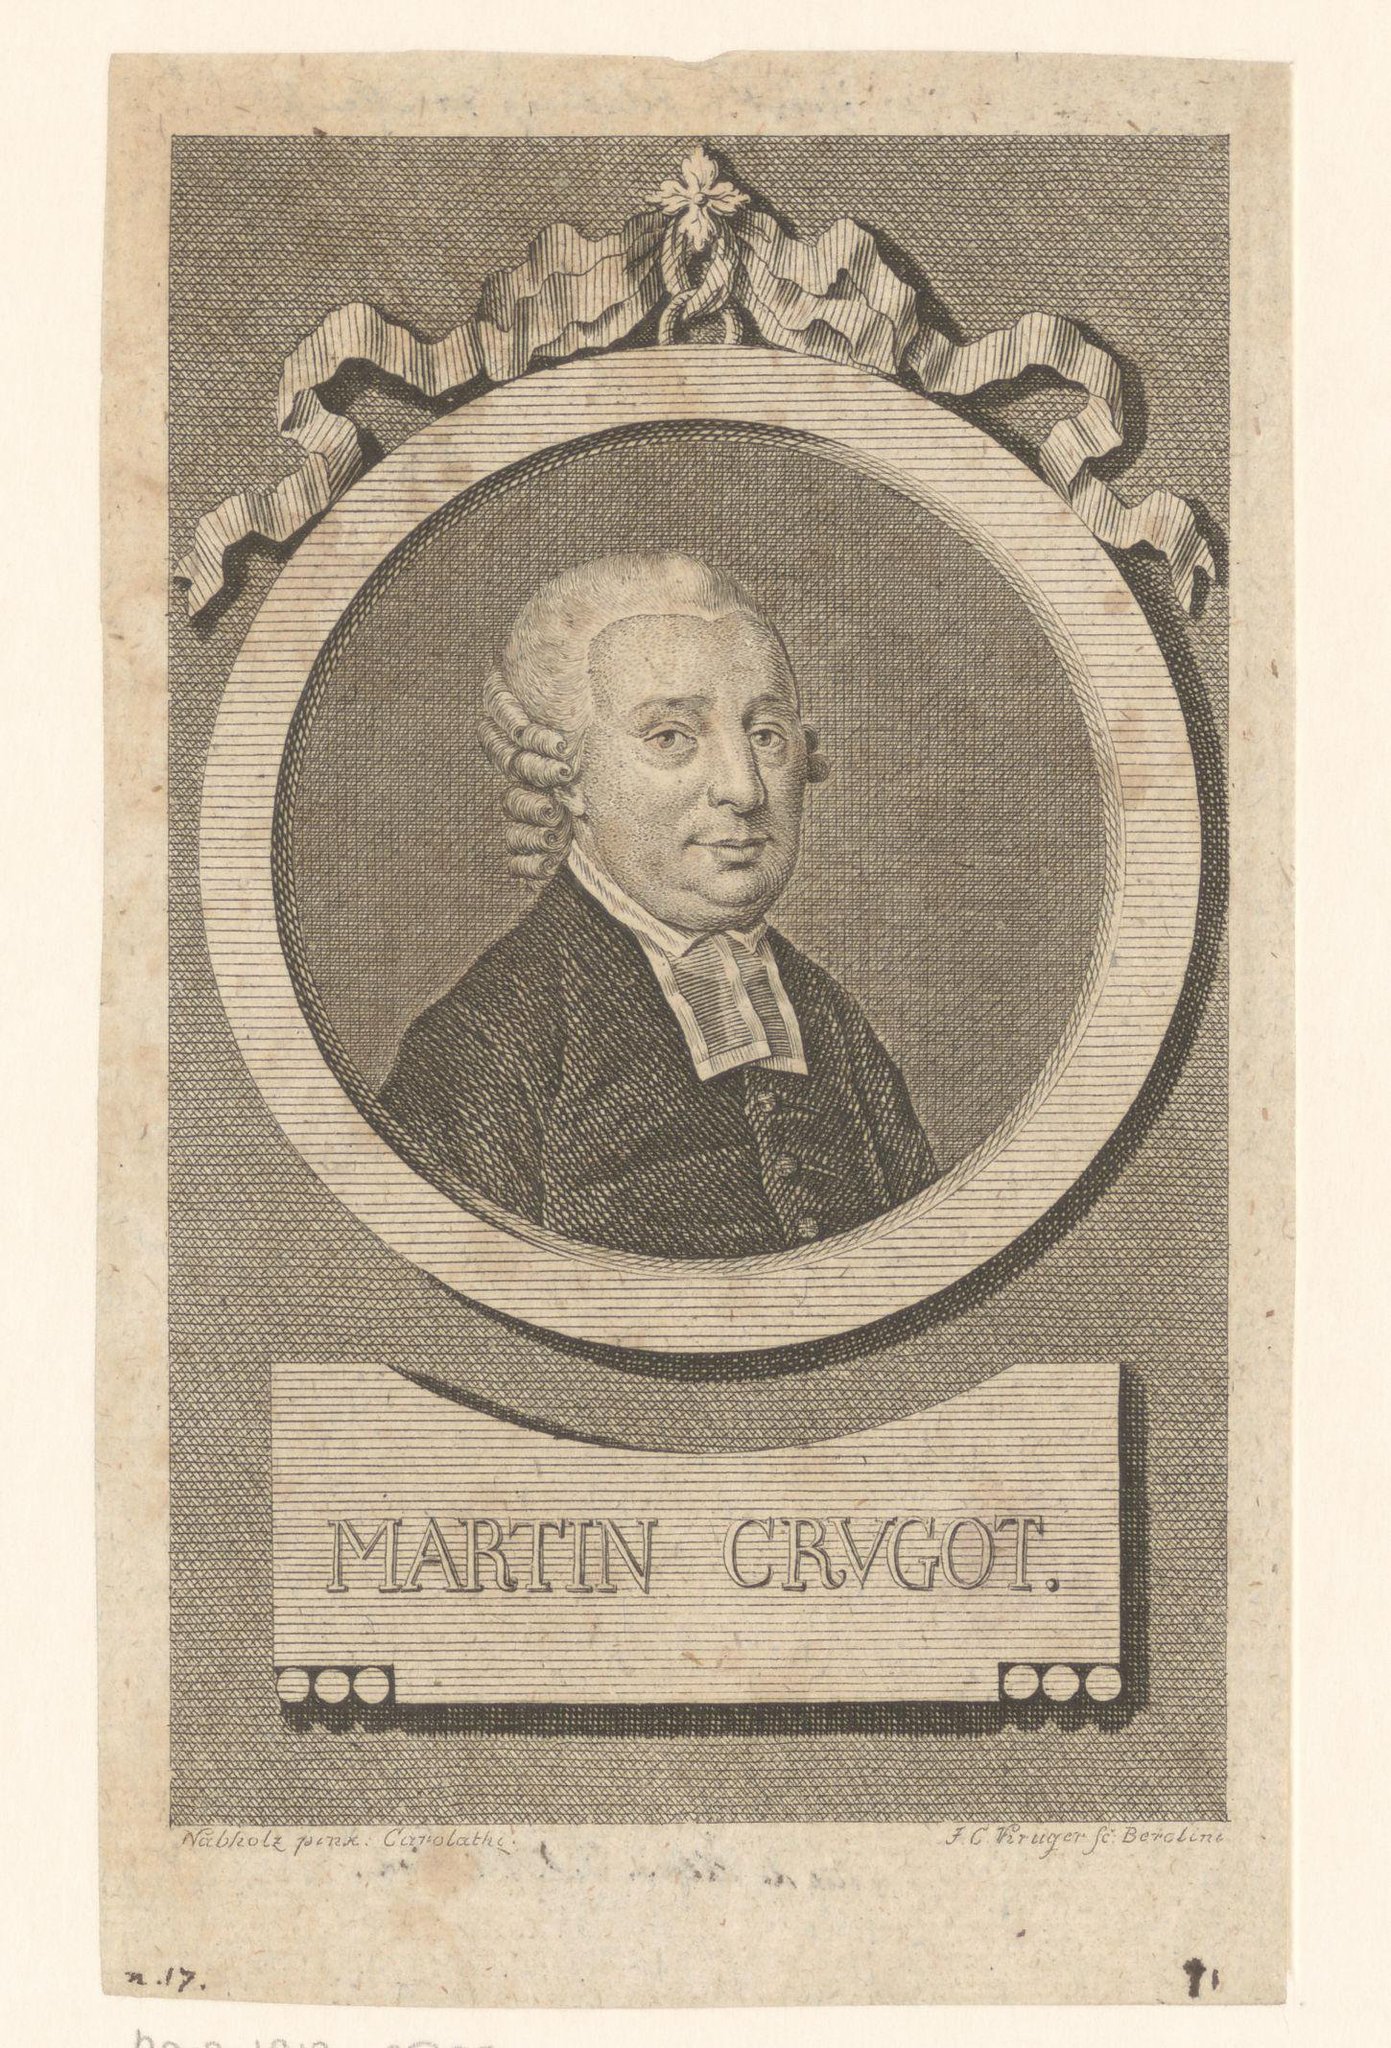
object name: print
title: Portret van Martin Crugot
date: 1778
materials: paper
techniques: engraving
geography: berlin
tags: historical persons, mathematics (+ portrait of scholar, scientist)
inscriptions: collector's mark: Lugt 2228, number: ‘17’